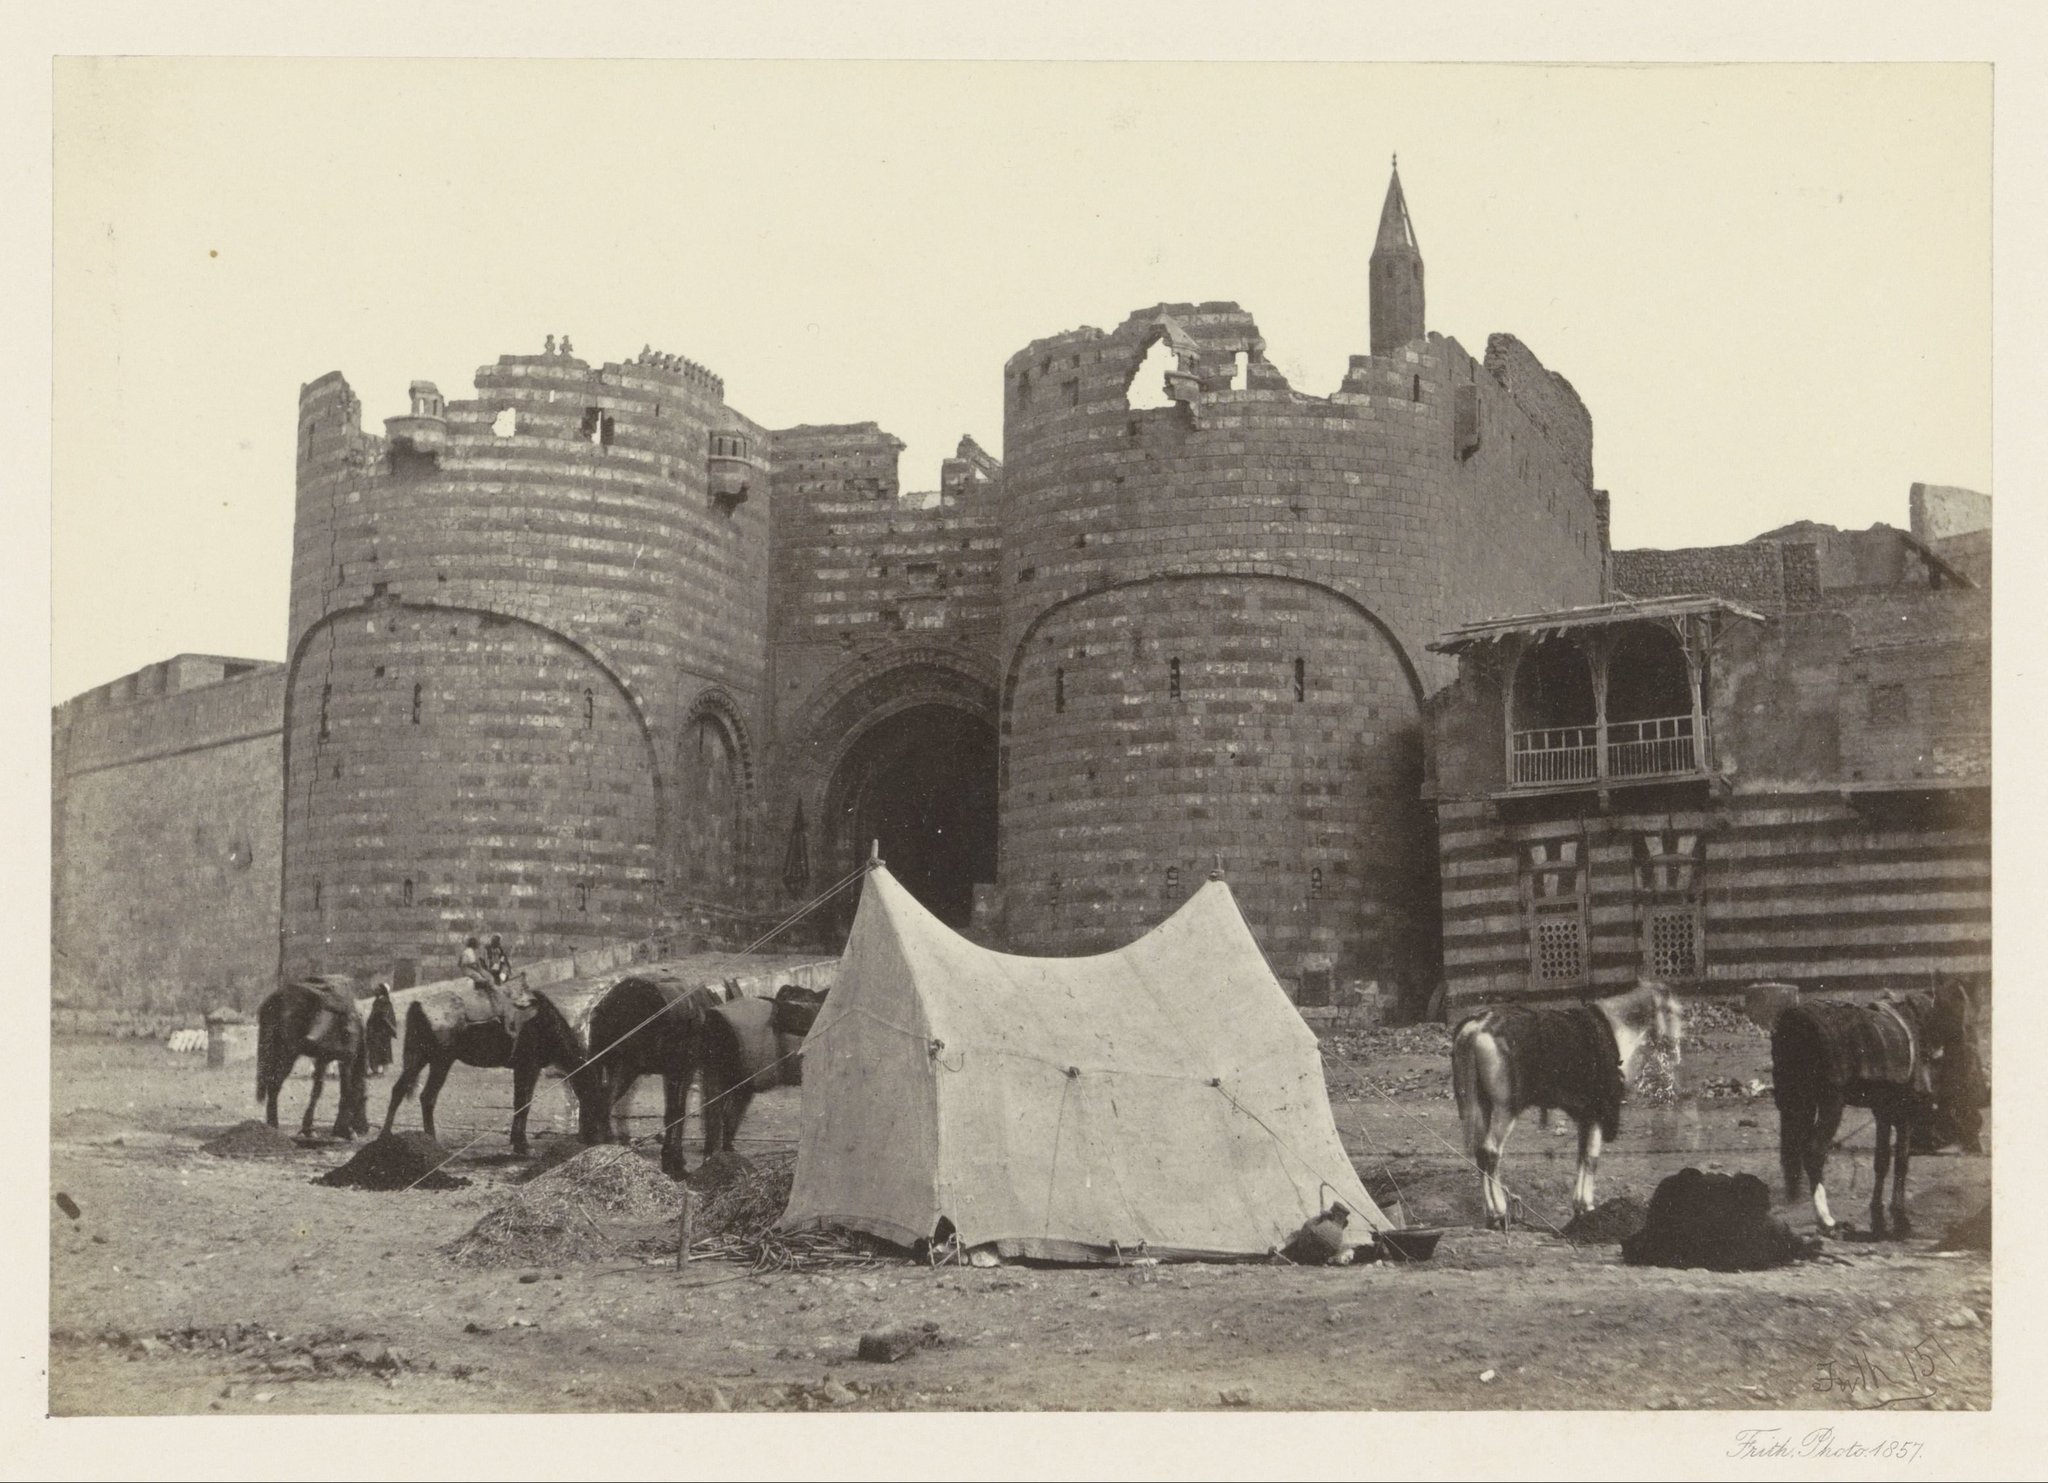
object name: photograph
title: Gezicht op Bab al-Azab, poort naar de citadel van Caïro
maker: francis frith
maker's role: publisher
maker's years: 1822-1898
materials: paper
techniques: albumen print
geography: cairo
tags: gate, entrance, fortified city